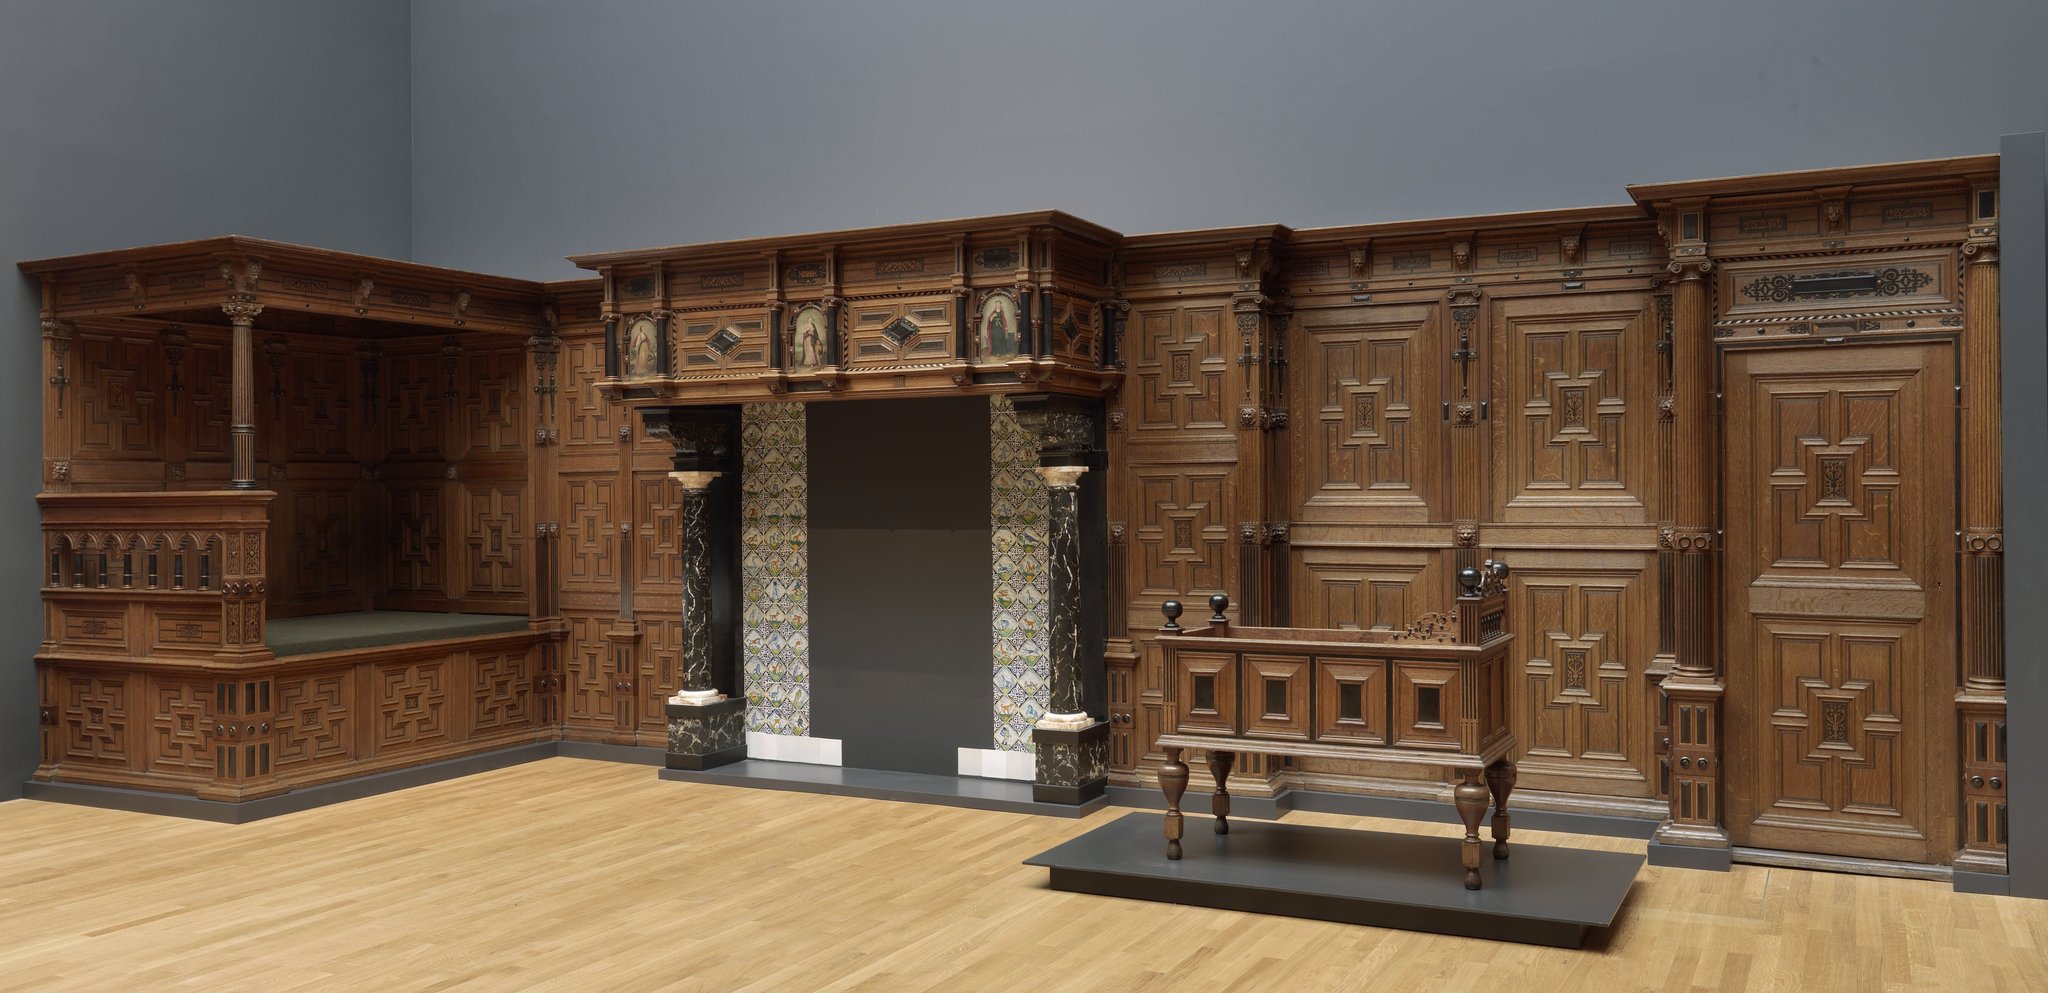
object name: tile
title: Tegels, onderdeel van betimmering 1626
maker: Anonymous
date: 1626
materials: marble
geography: northern netherlands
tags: dordrecht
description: Twee kratten met de tegels van het inetrieuronderdeel.